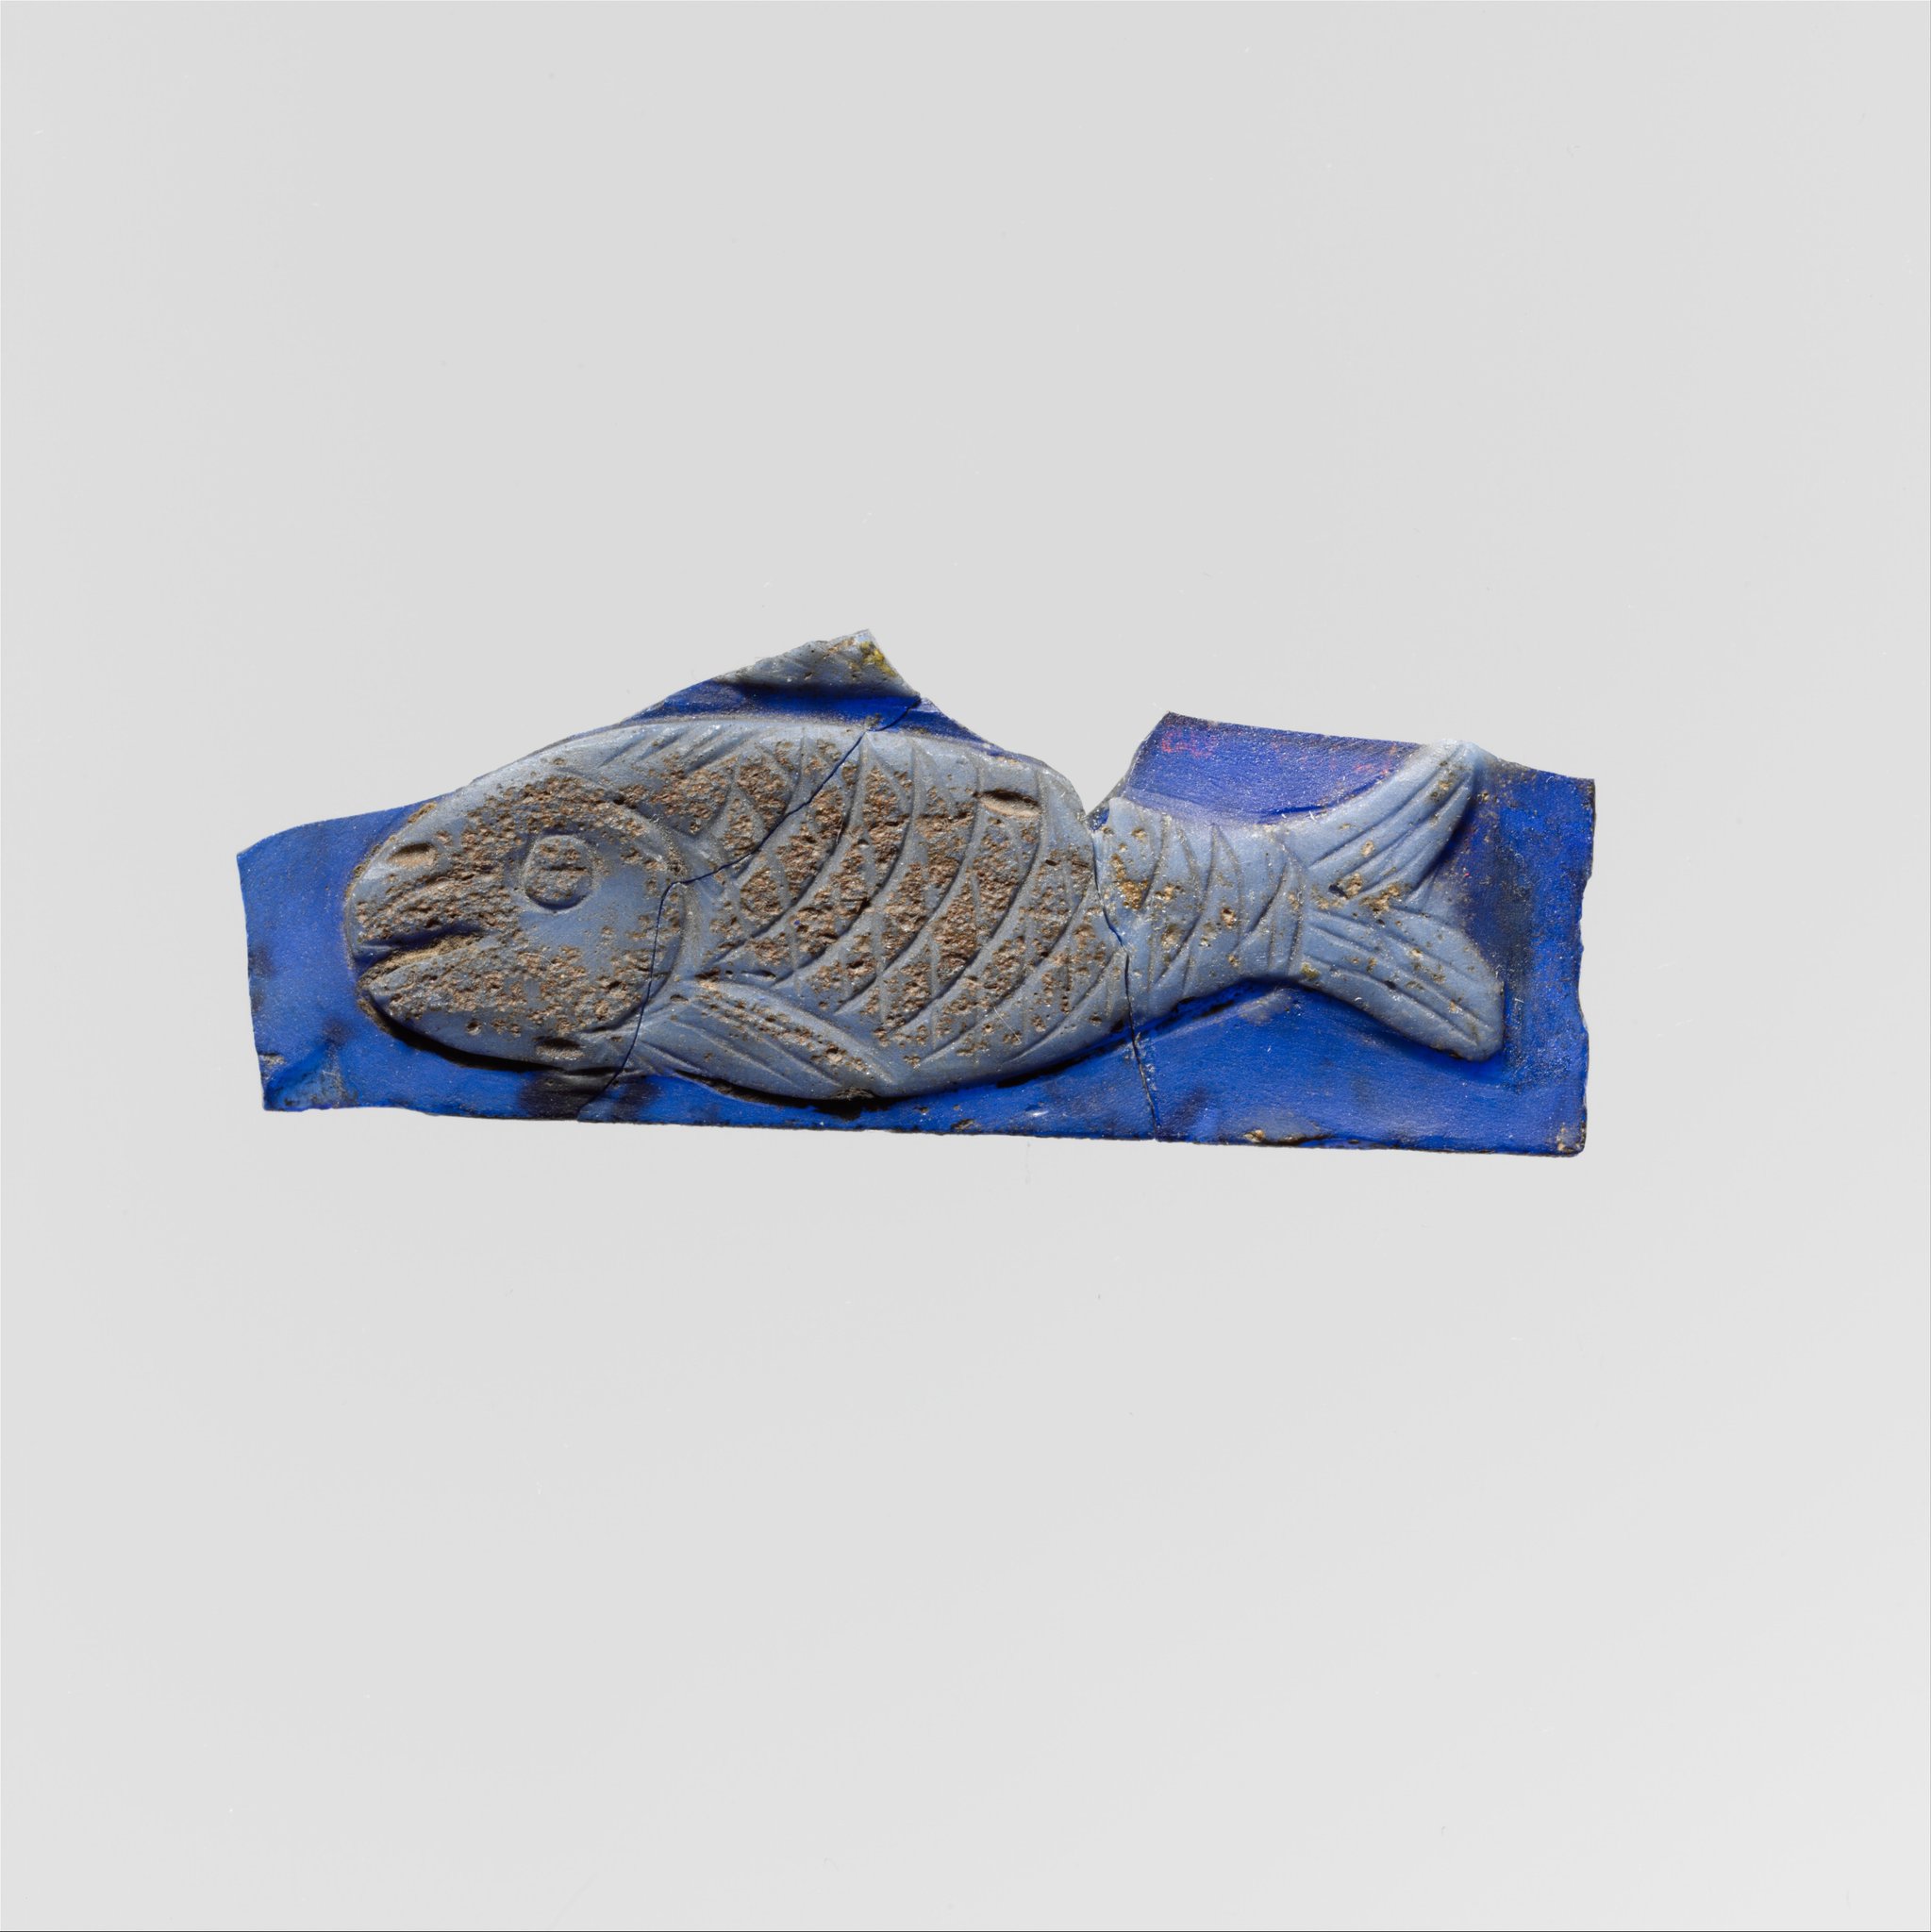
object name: relief with fish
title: Glass cameo fragment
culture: roman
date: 1-50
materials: glass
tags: fish